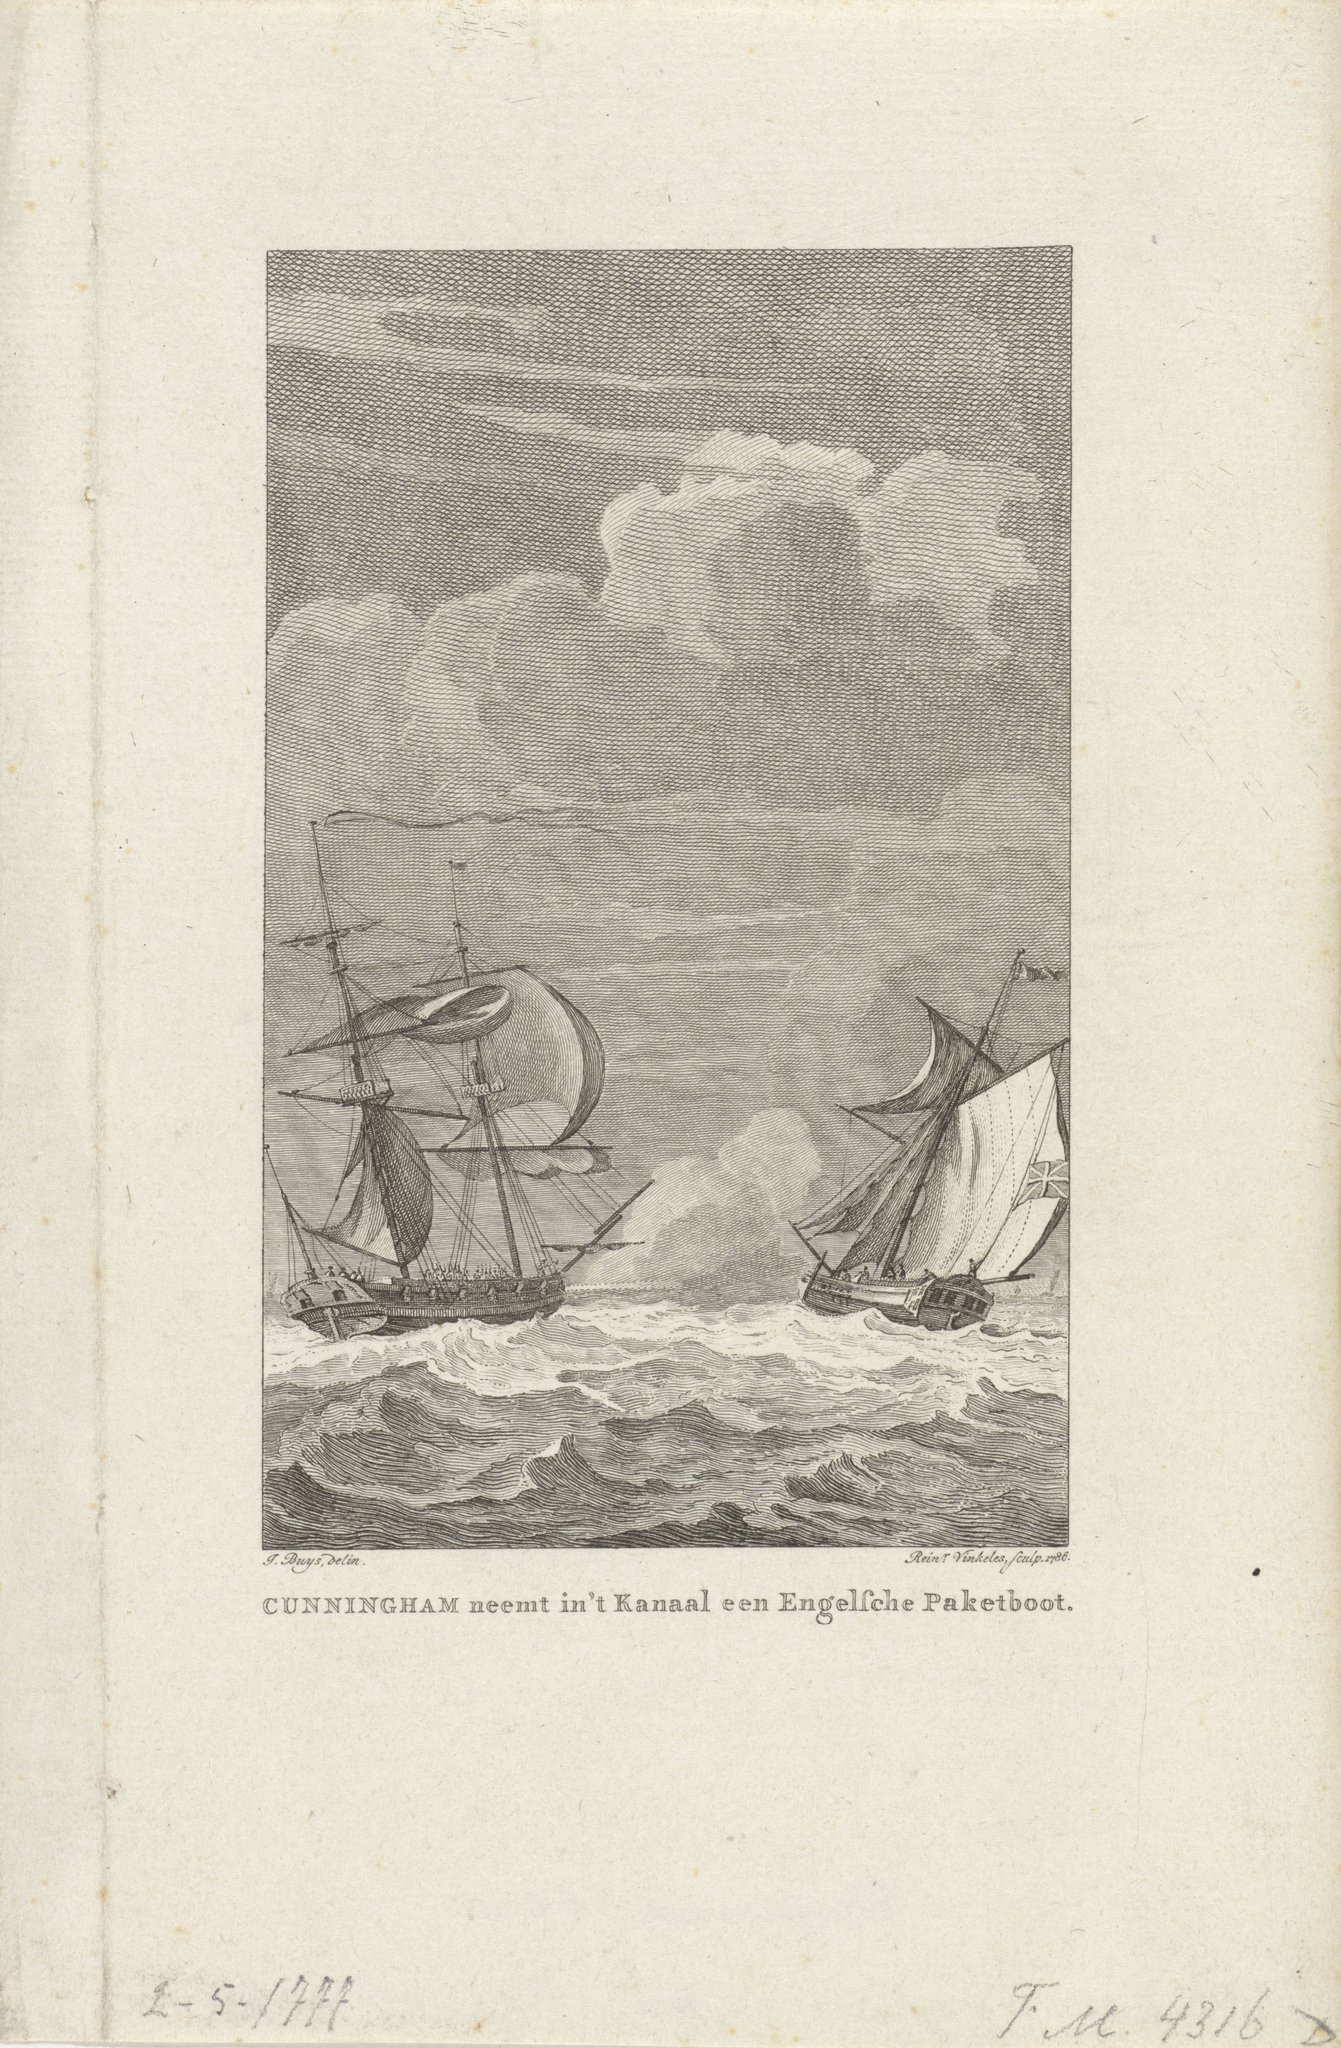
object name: history print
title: Amerikaanse kaper Cunningham neemt een Engels schip, 1777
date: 1786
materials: paper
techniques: engraving, etching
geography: amsterdam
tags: piracy, english channel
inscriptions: date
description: Gebruikt als illustratie in: P.A. Loosjes. Vaderlandsche historie, vervattende de geschiedenissen, der Vereenigde Nederlanden (...). Ten onmiddelyken vervolge van Wagenaar's Vaderlandsche historie. Amsterdam: J. Allart.